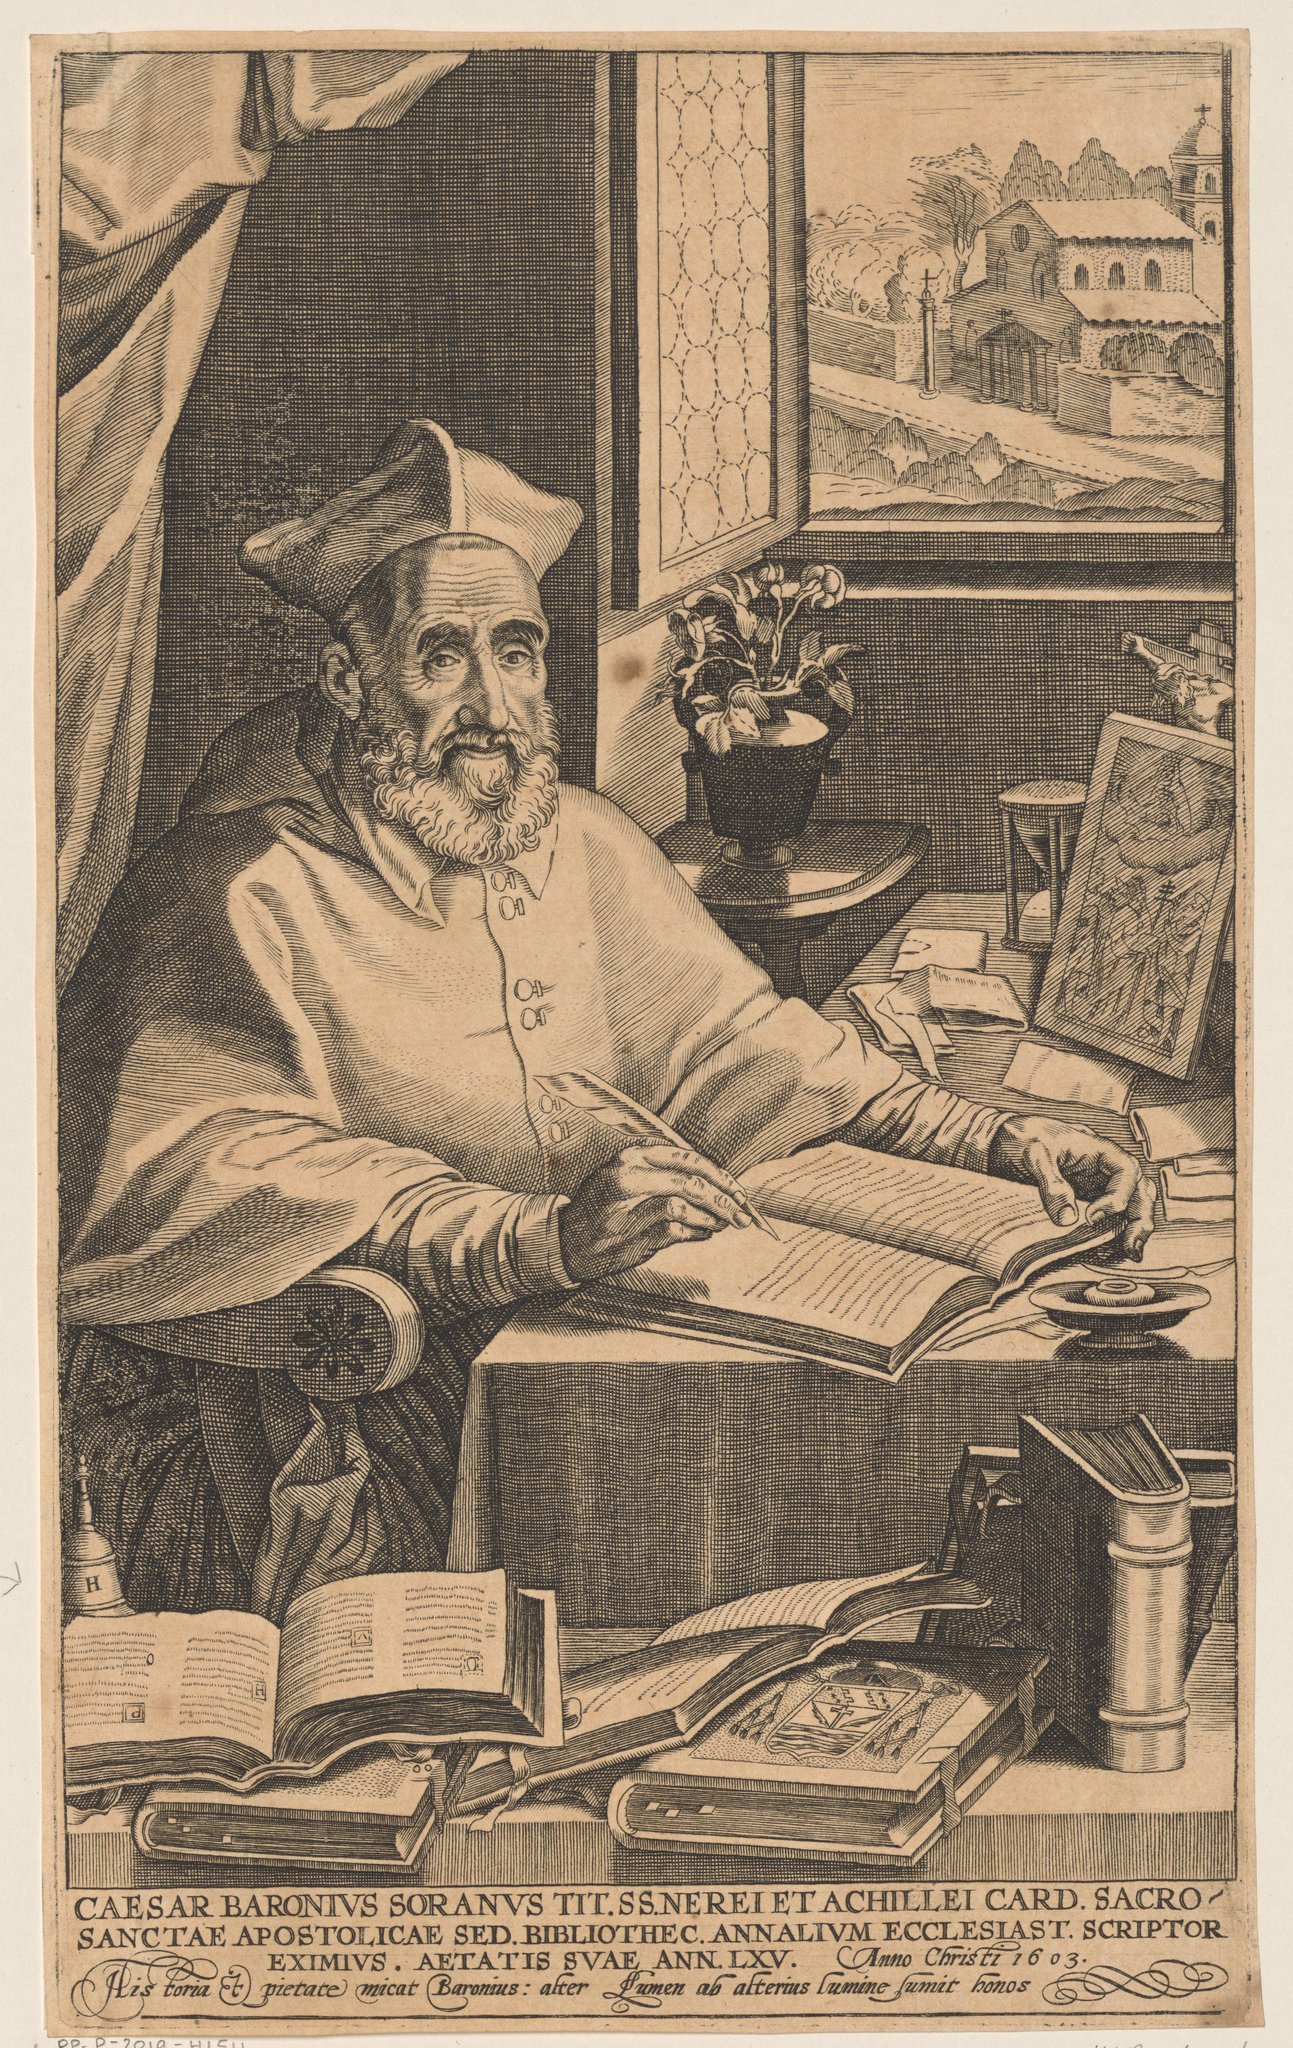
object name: print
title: Portret van kardinaal Cesare Baronio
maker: johann hogenberg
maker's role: print maker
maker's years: 1550-1618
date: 1603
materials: paper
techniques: engraving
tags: rome, city-view in general; 'veduta', historical persons, book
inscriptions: date